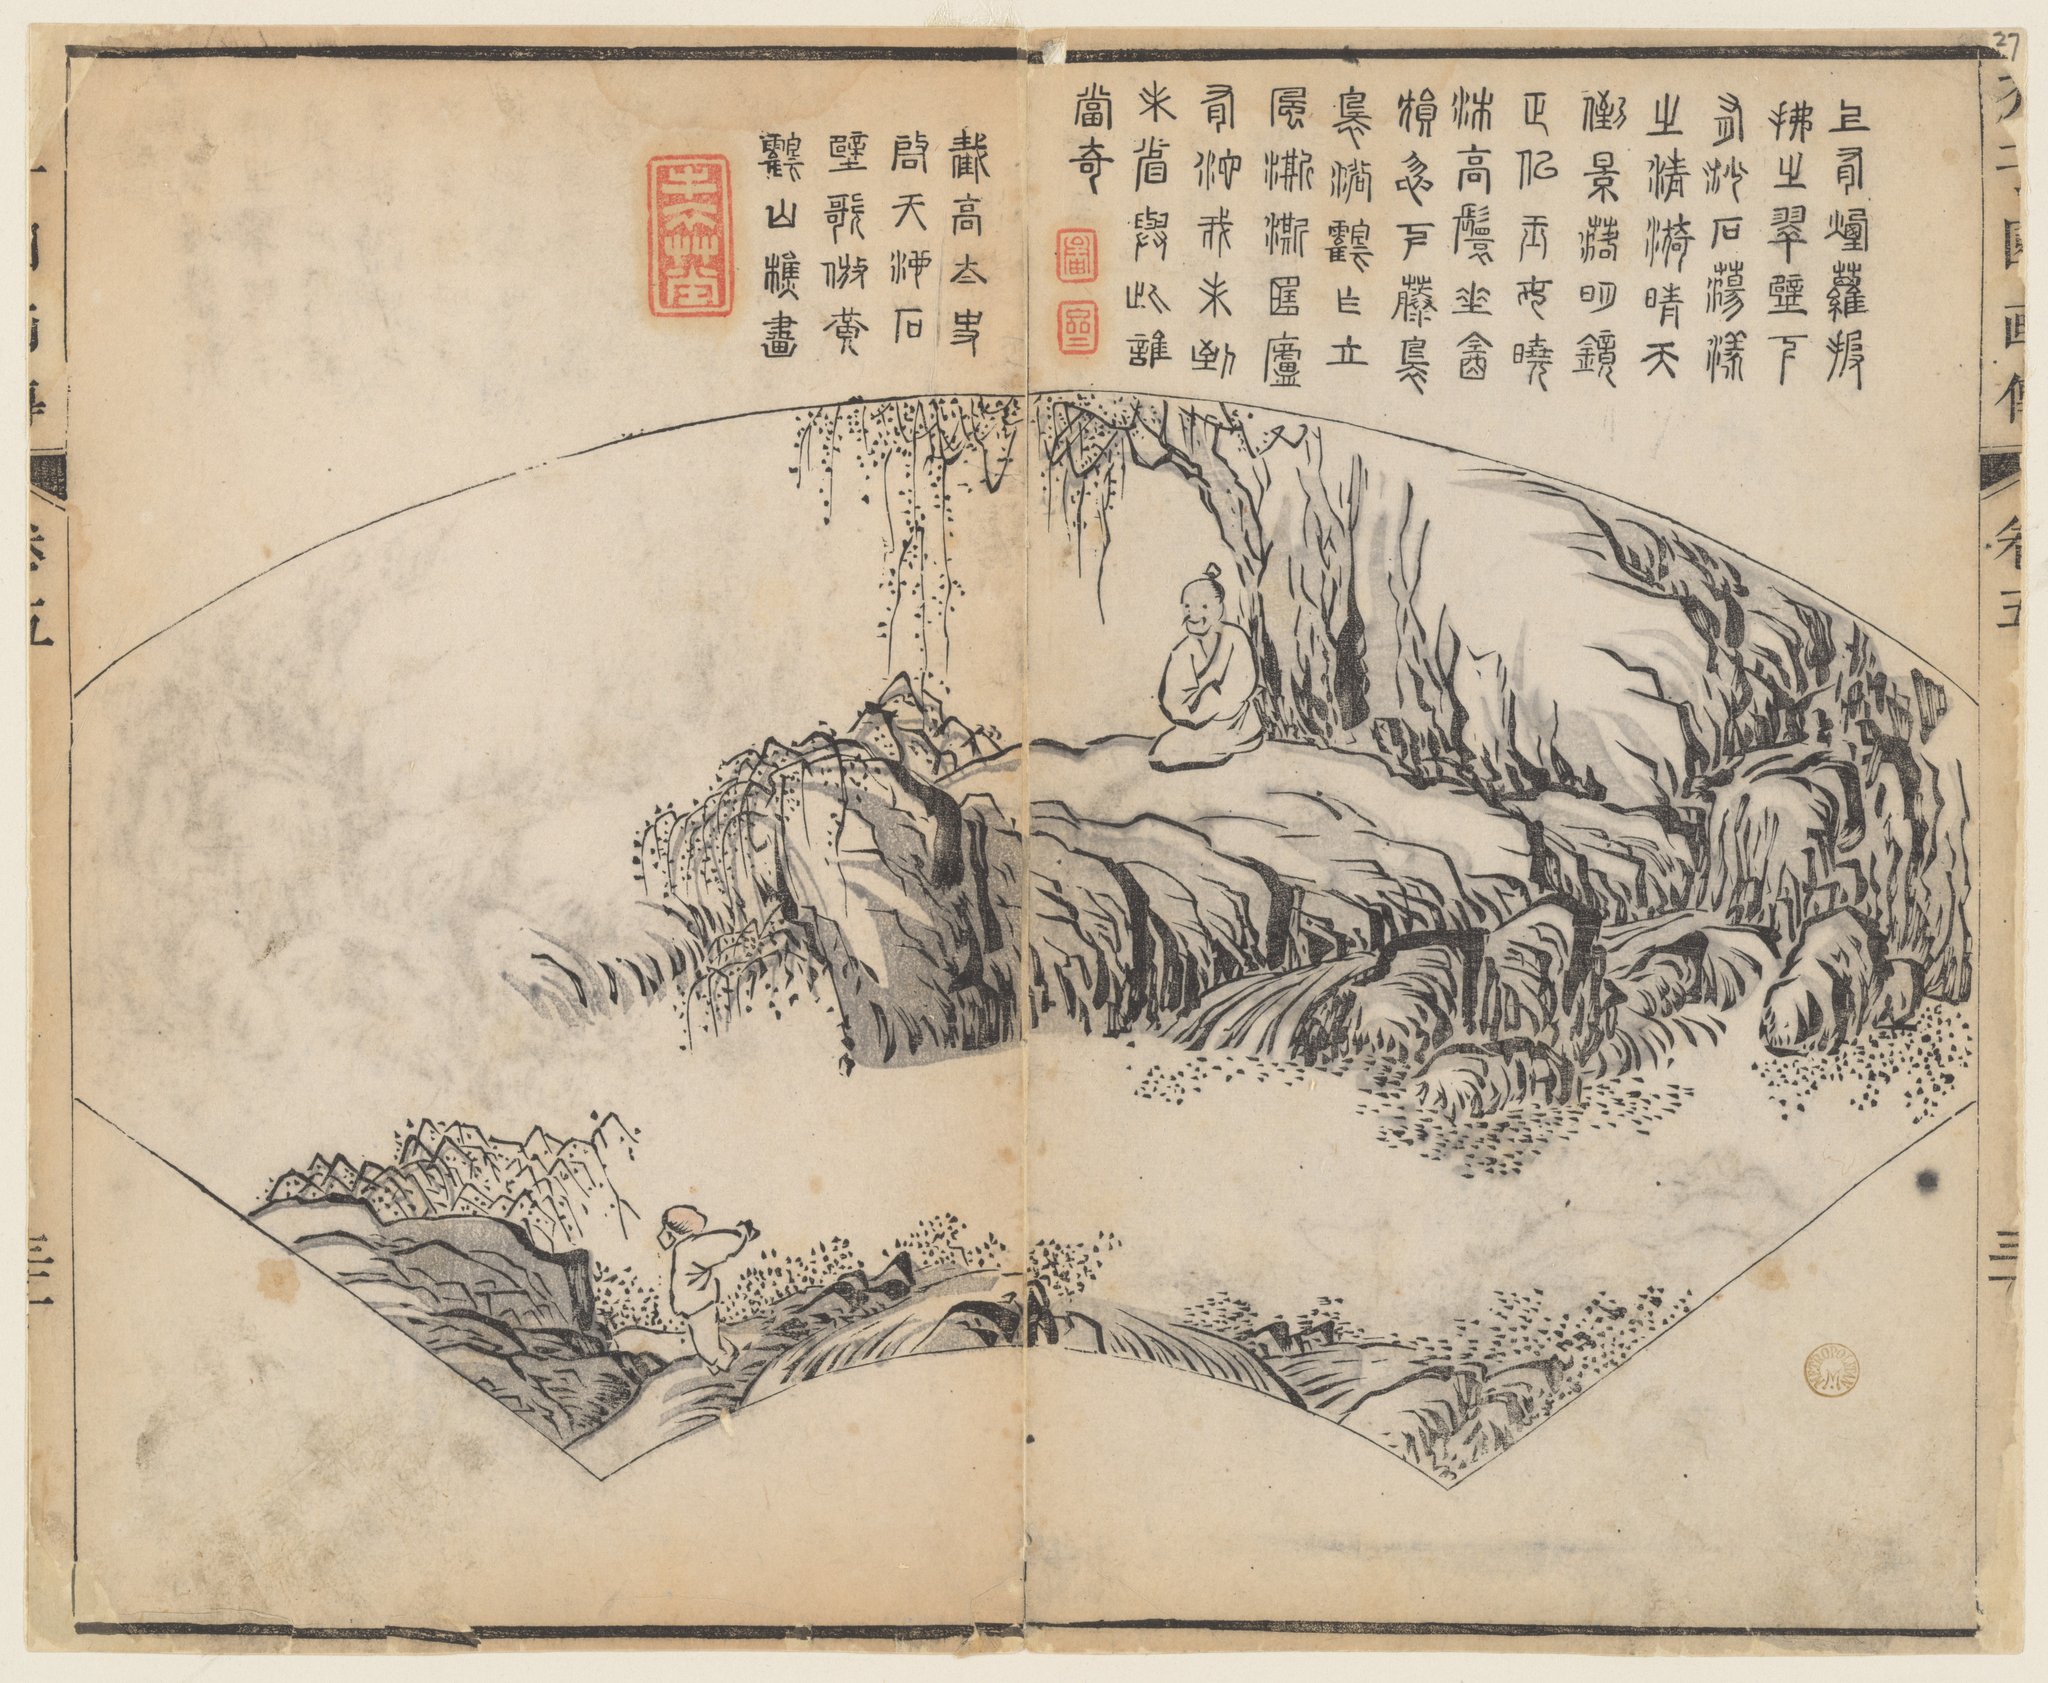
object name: print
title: Page from the Mustard Seed Garden Manual of Painting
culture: chinese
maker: wang gai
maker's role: artist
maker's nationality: chinese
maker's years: 1645-1710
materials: ink, paper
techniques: woodblock print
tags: landscapes